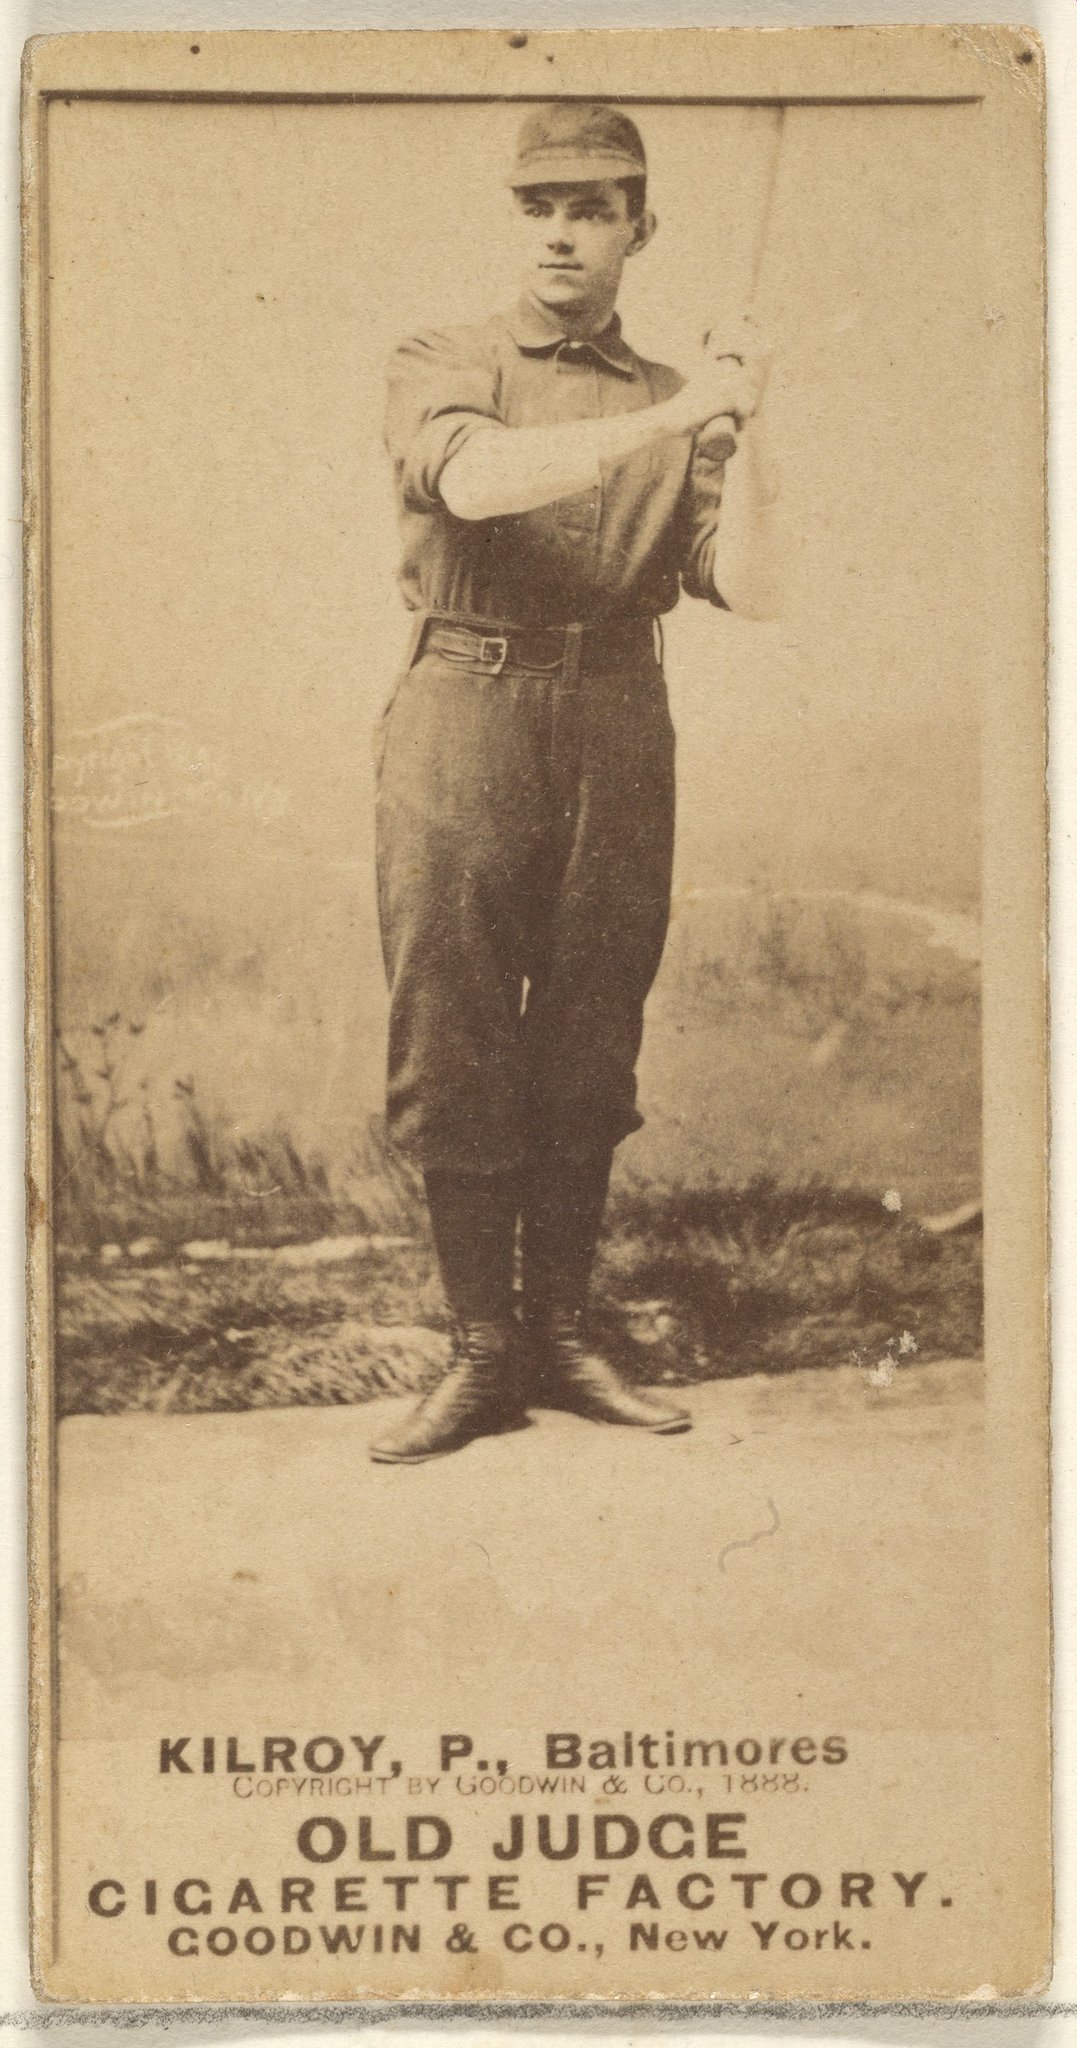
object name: baseball card, photograph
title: Kilroy, Pitcher, Baltimore Orioles, from the Old Judge series (N172) for Old Judge Cigarettes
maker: goodwin & company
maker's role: publisher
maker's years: 1850-1950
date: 1888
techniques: albumen silver print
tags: men,portraits,baseball,athletes